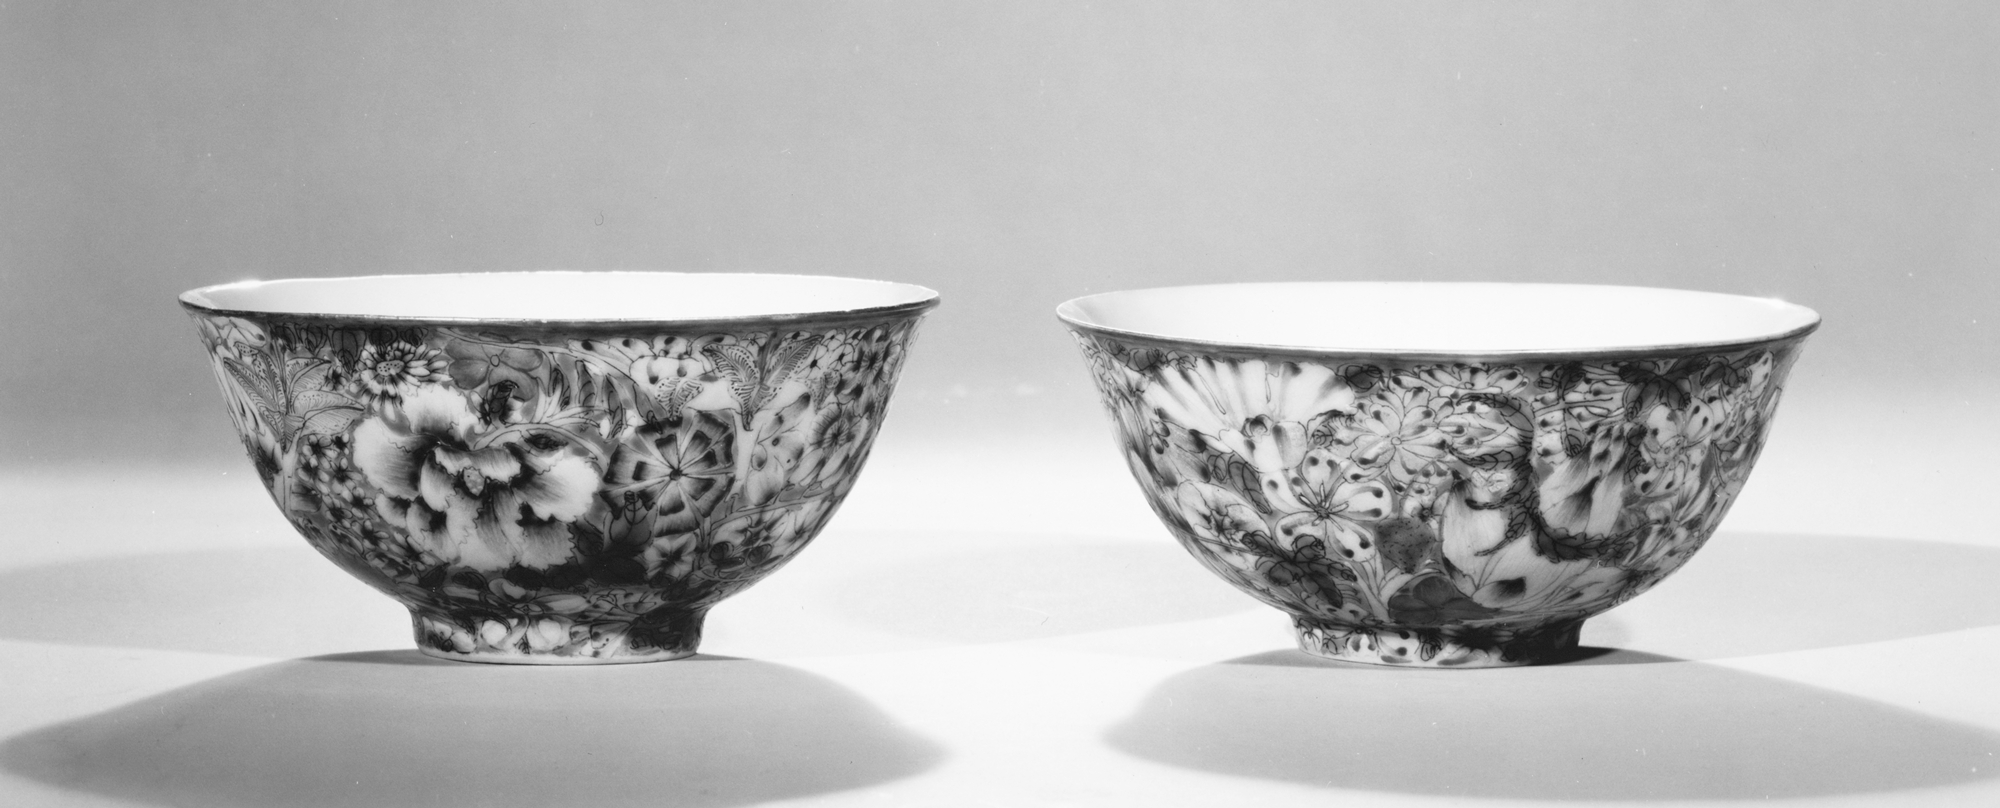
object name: bowl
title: Bowl (one of a pair)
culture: chinese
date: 1916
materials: porcelain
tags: flowers